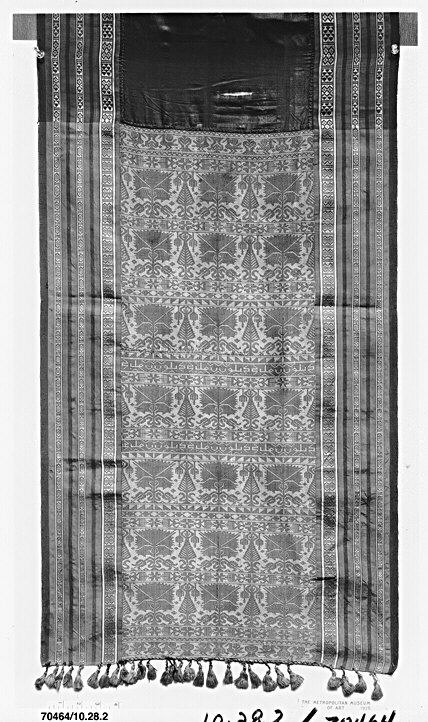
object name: headcovering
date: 1801-1900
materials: silk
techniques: weave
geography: tunisia